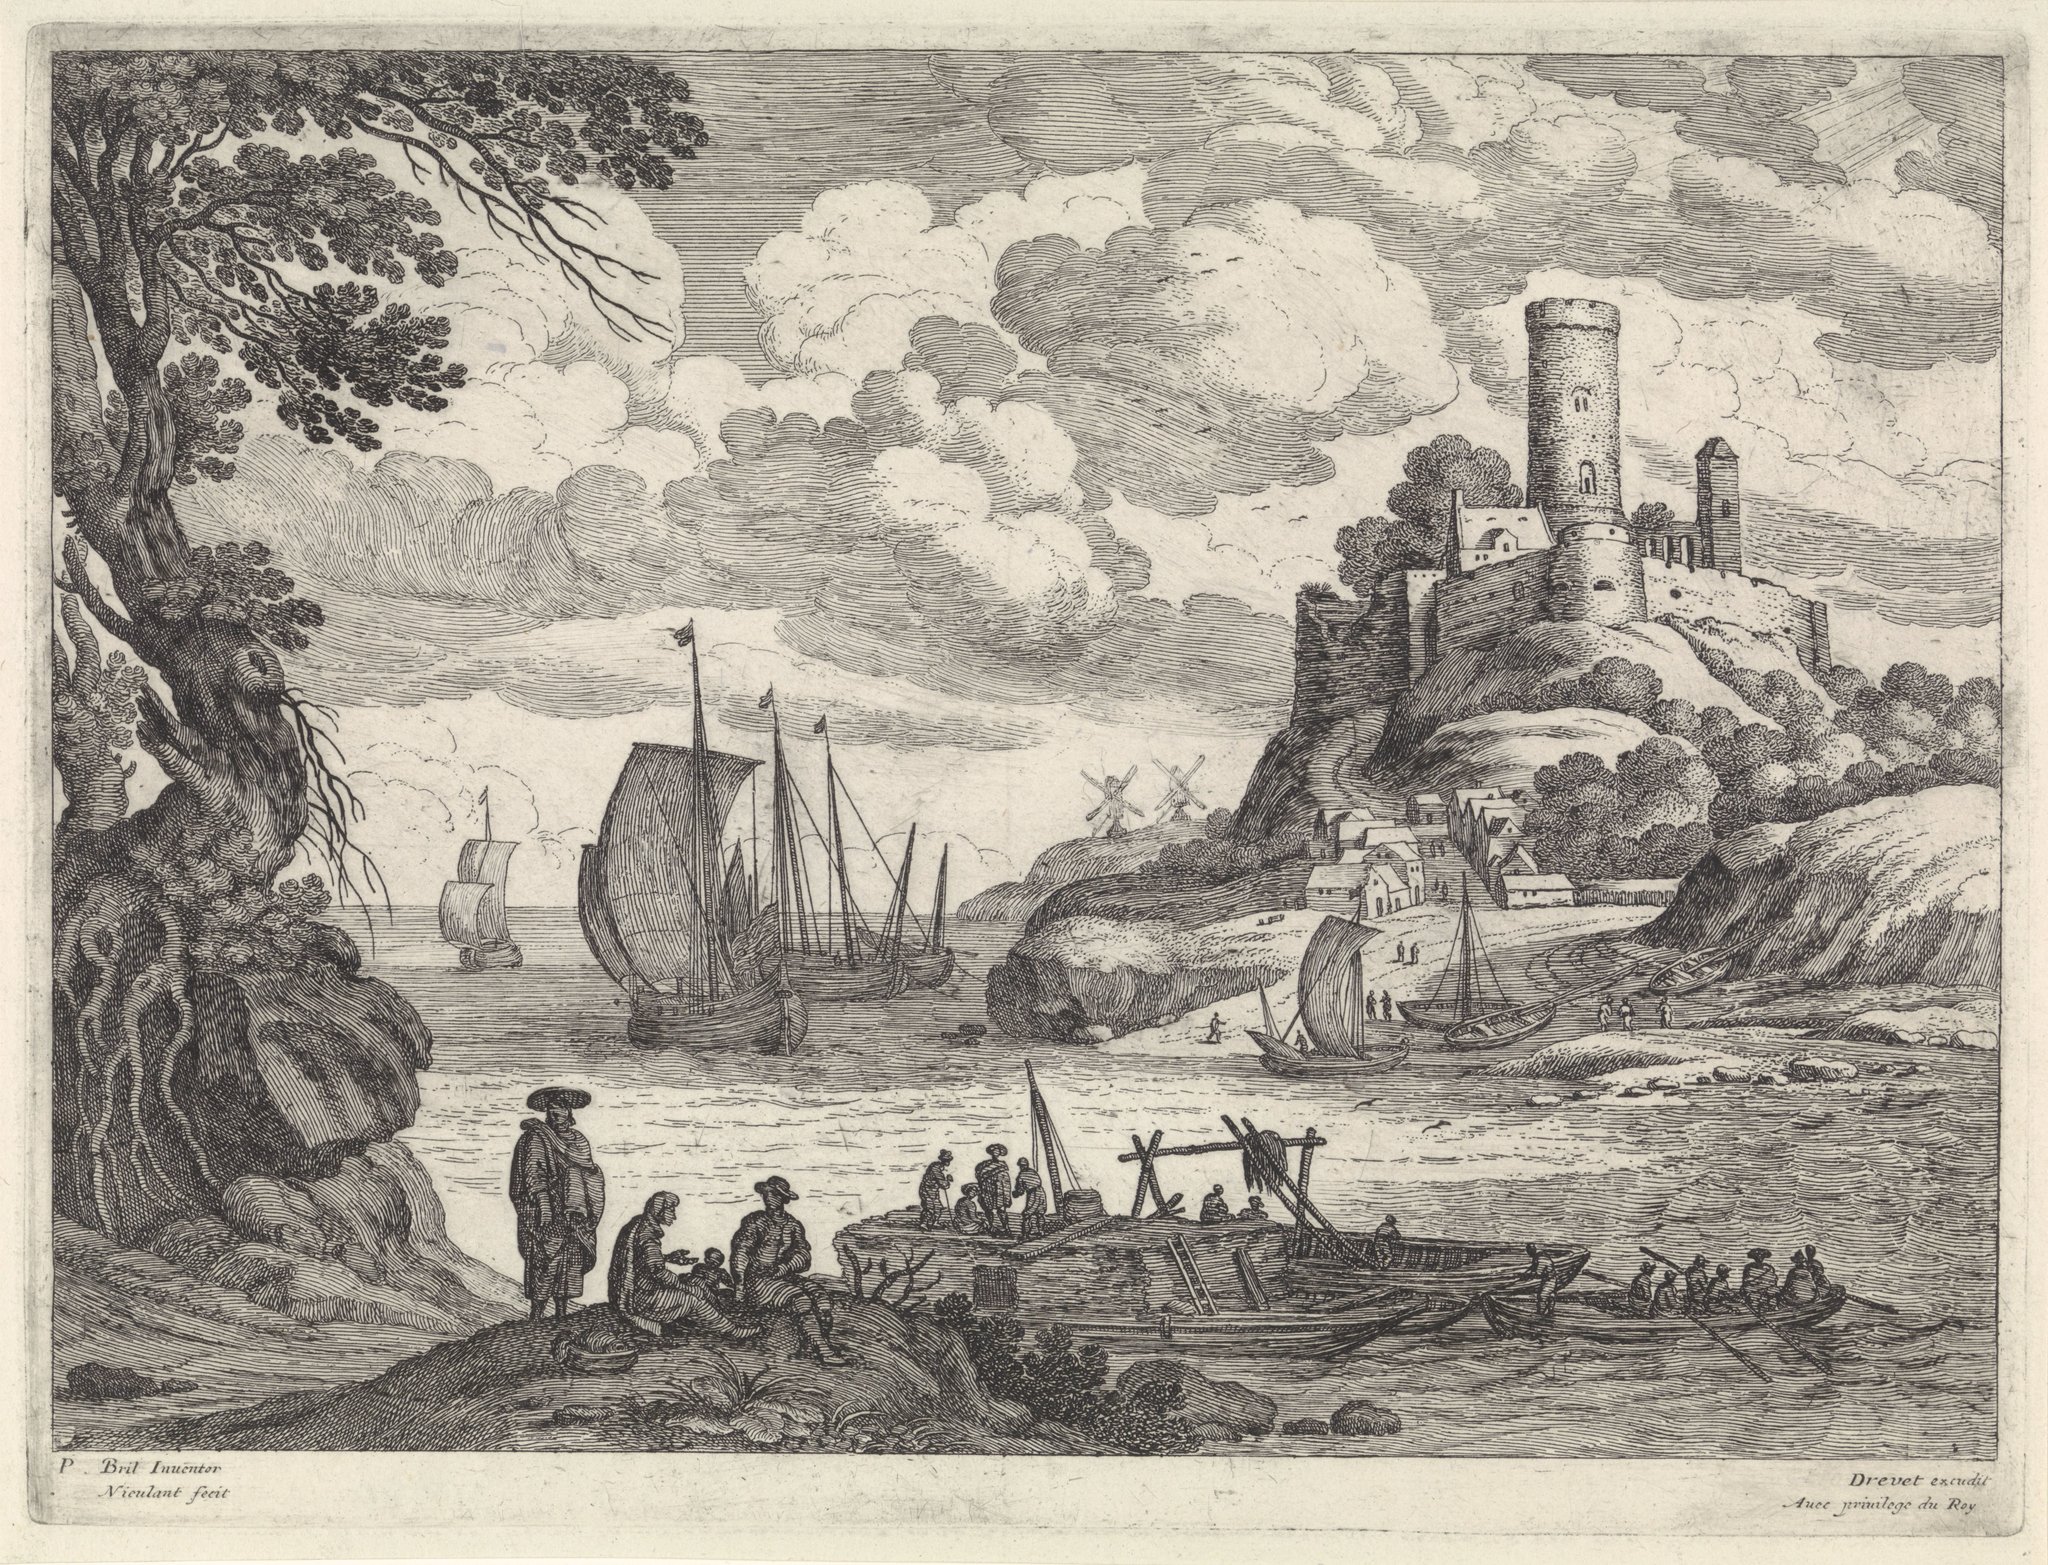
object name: print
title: Havengezicht met schepen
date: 1594-1635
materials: paper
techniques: etching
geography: france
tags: harbour, fortress, sailing-ship, sailing-boat, rowing-boat, canoe, etc.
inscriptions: collector's mark: Lugt 2228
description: Verschillende schepen liggen voor anker in een riviermonding, die uitkomt op zee. Rechts aan de overzijde van het water ligt een burcht met een toren, met links daarvan twee windmolens. Op de voorgrond liggen een schip met lading en een roeiboot met bemanning.